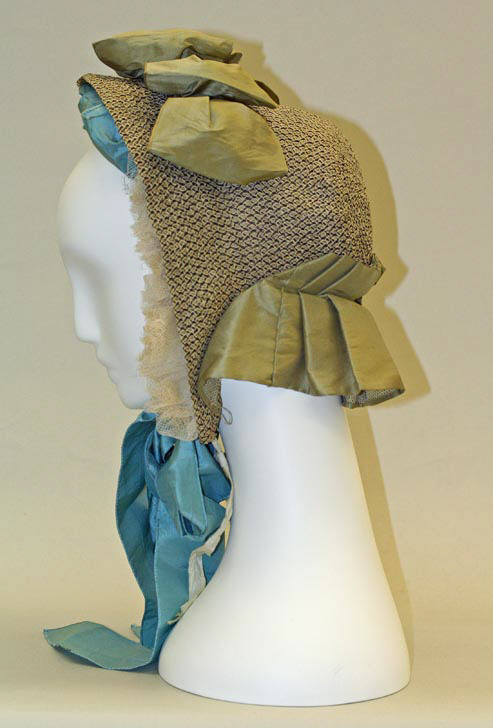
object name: bonnet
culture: american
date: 1853-1854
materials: hair, silk, fiber, metal